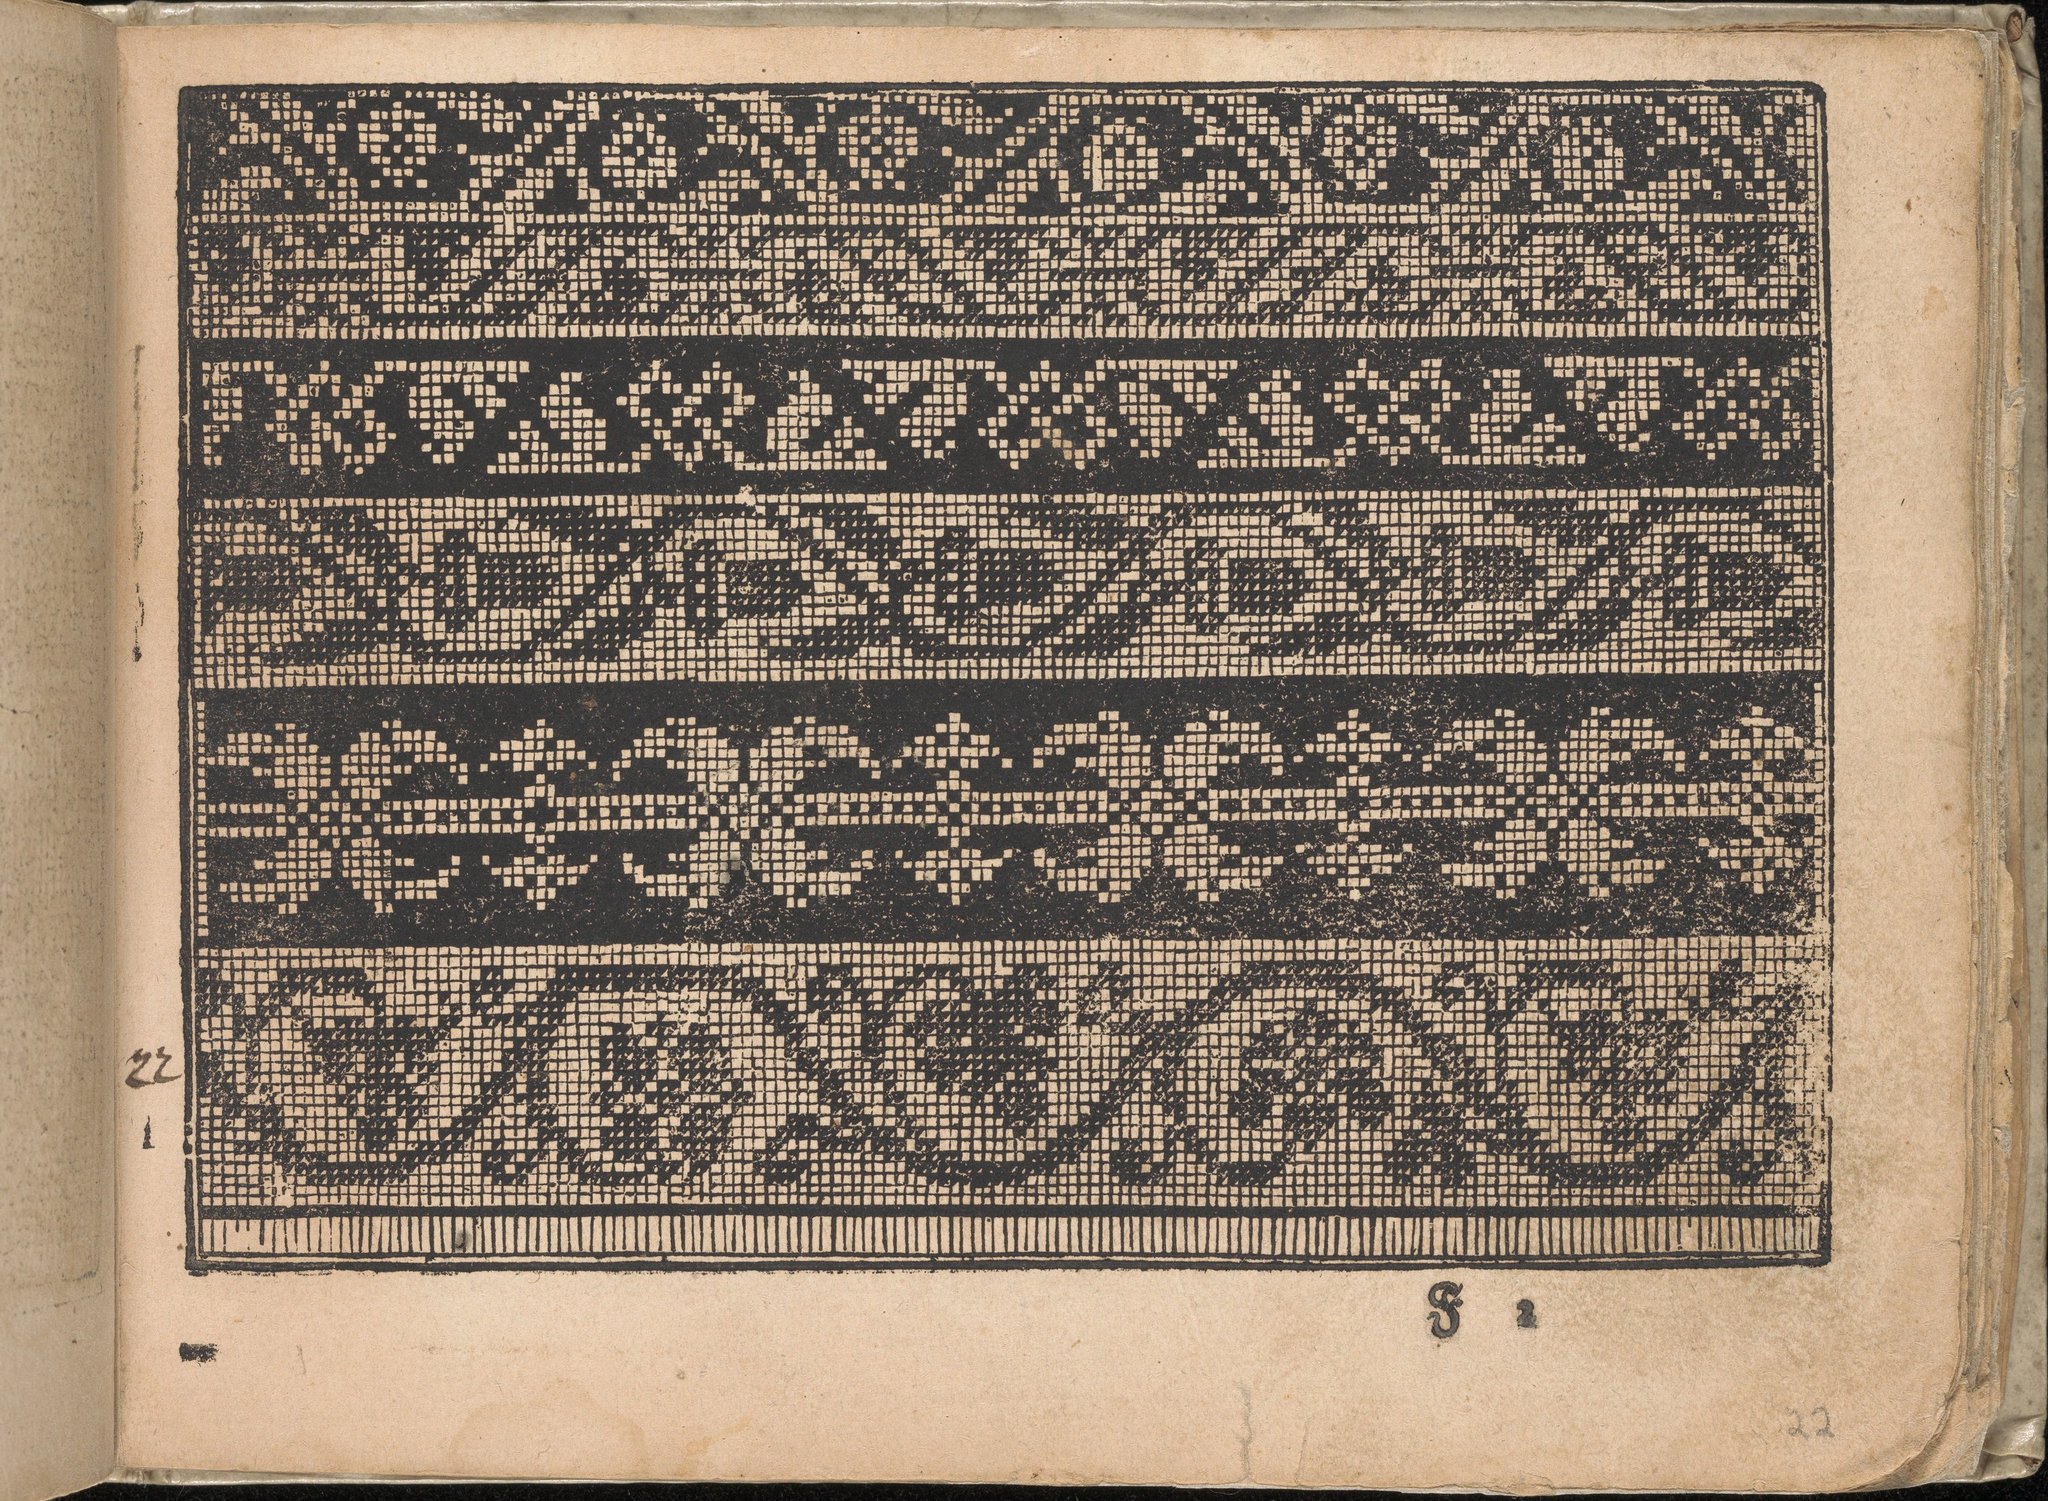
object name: book print ornament architecture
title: Neu künstlich Modelbuch (page 22r)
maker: bernhard jobin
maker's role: publisher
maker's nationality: swiss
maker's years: 1535-1597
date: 1598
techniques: woodcut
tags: flowers